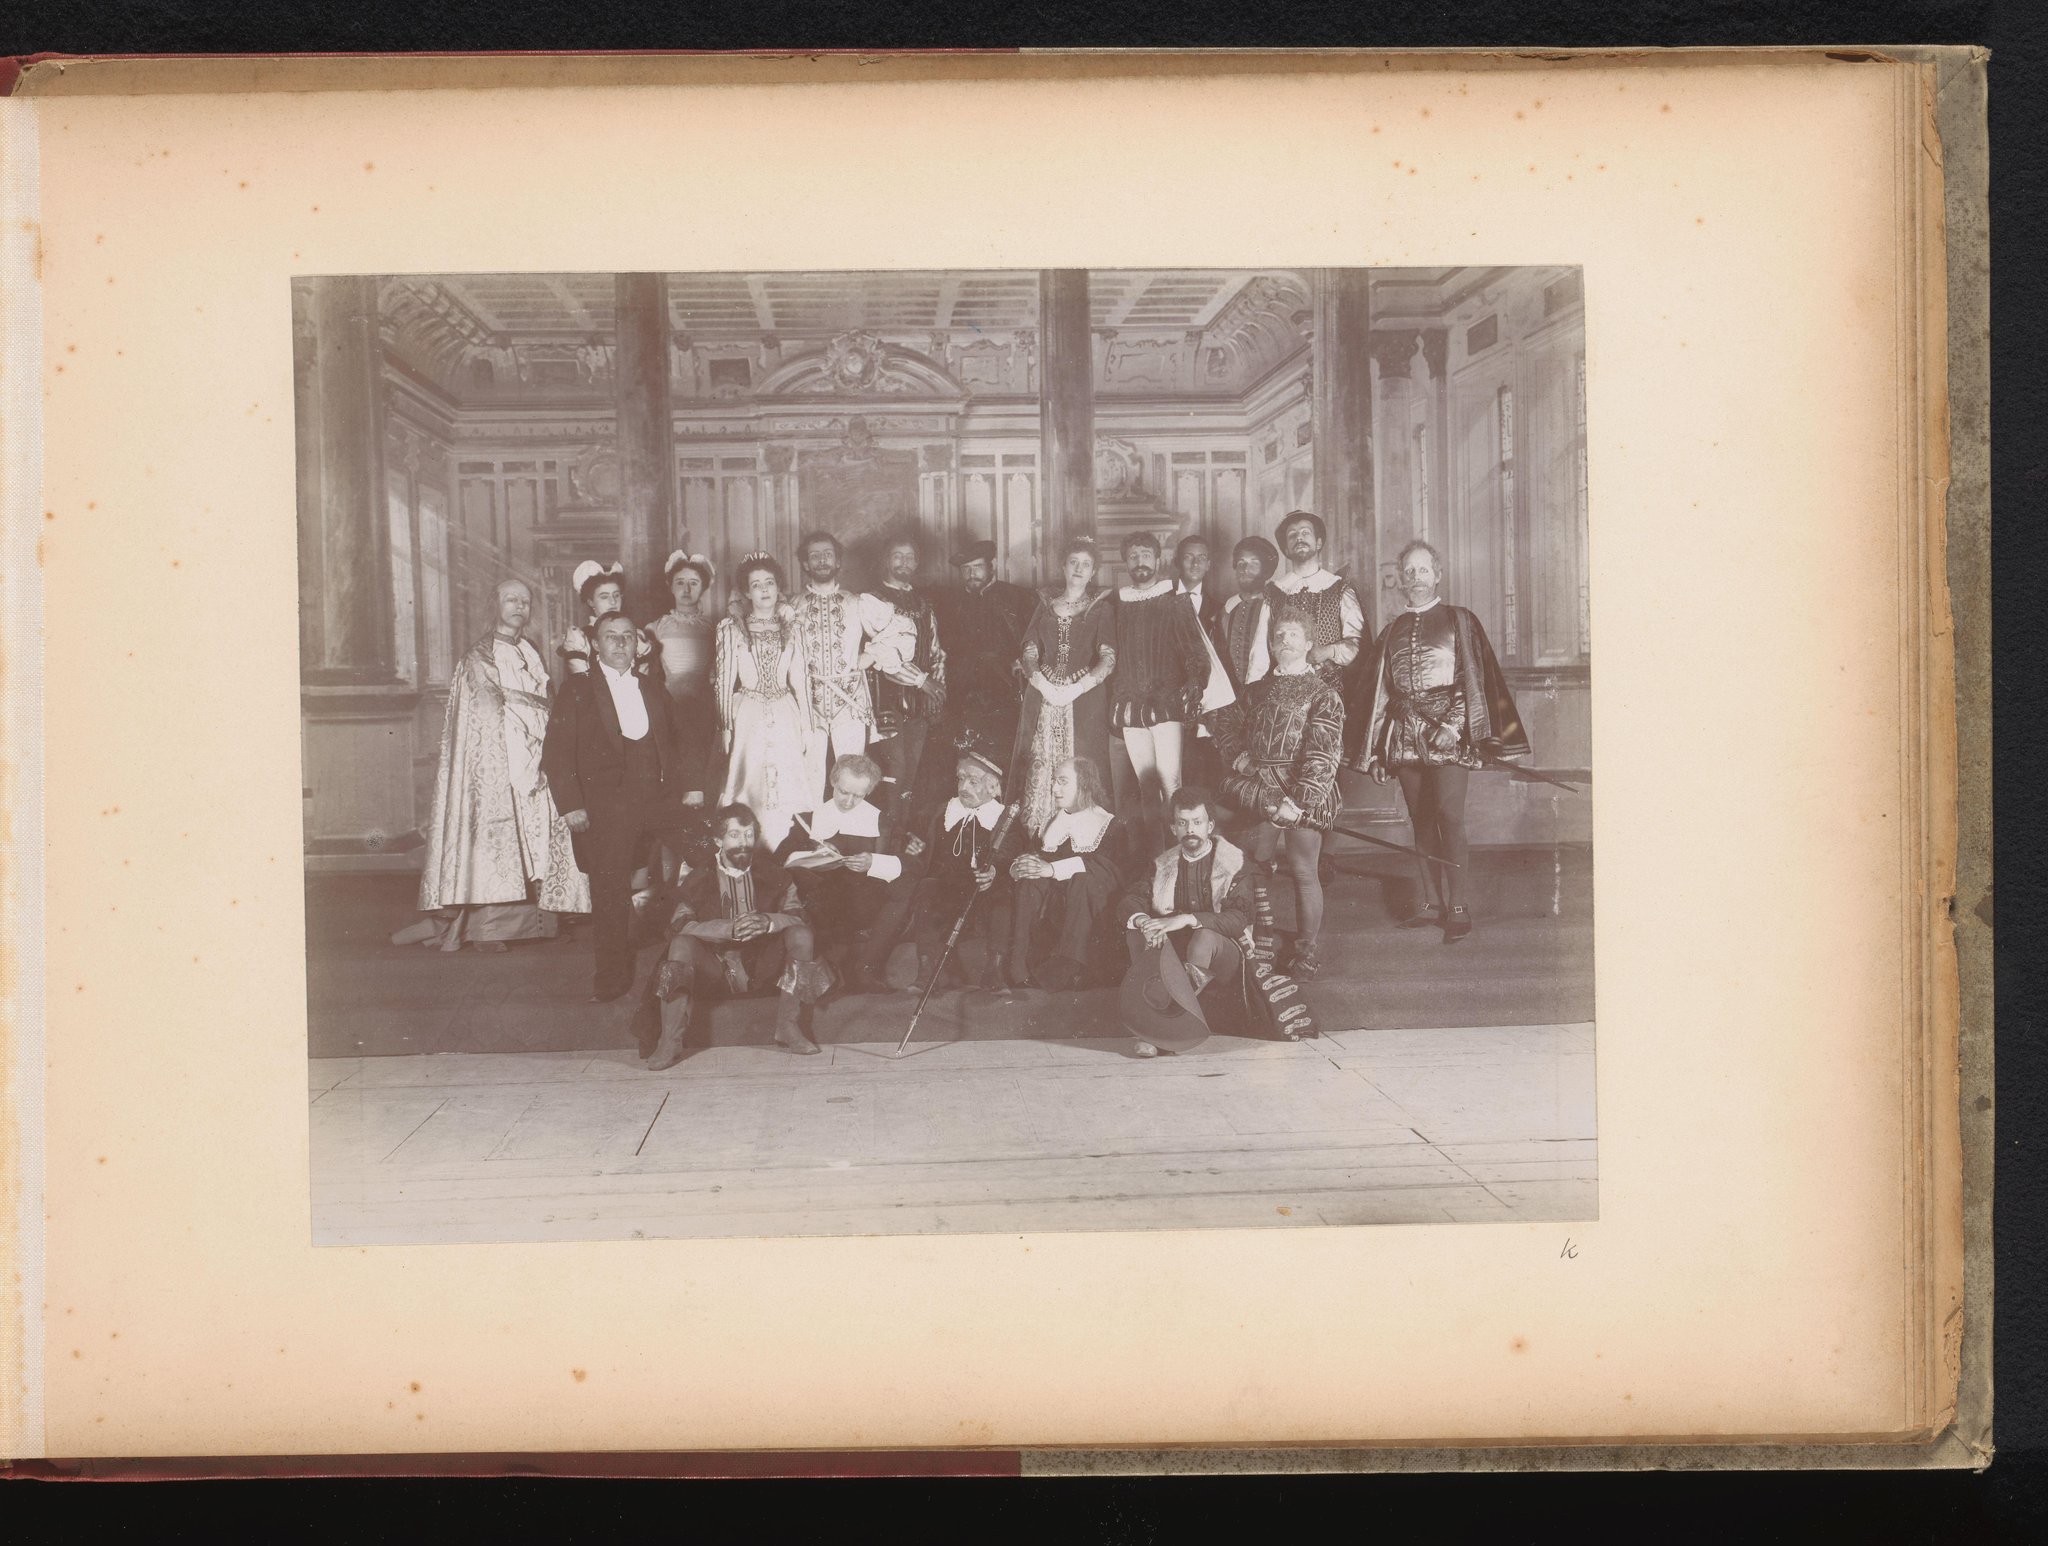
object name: album leaf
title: Groepsportret van leden van het Amsterdamsch Studenten Corps in kostuum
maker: nicolaas schuitvlot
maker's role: fotograaf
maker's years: 1859-1947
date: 1806-1897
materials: cardboard, photographic support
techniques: collodion silver print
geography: netherlands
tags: stage costume, students' organization, anonymous historical persons portrayed in a group, in a group-portrait, netherlands